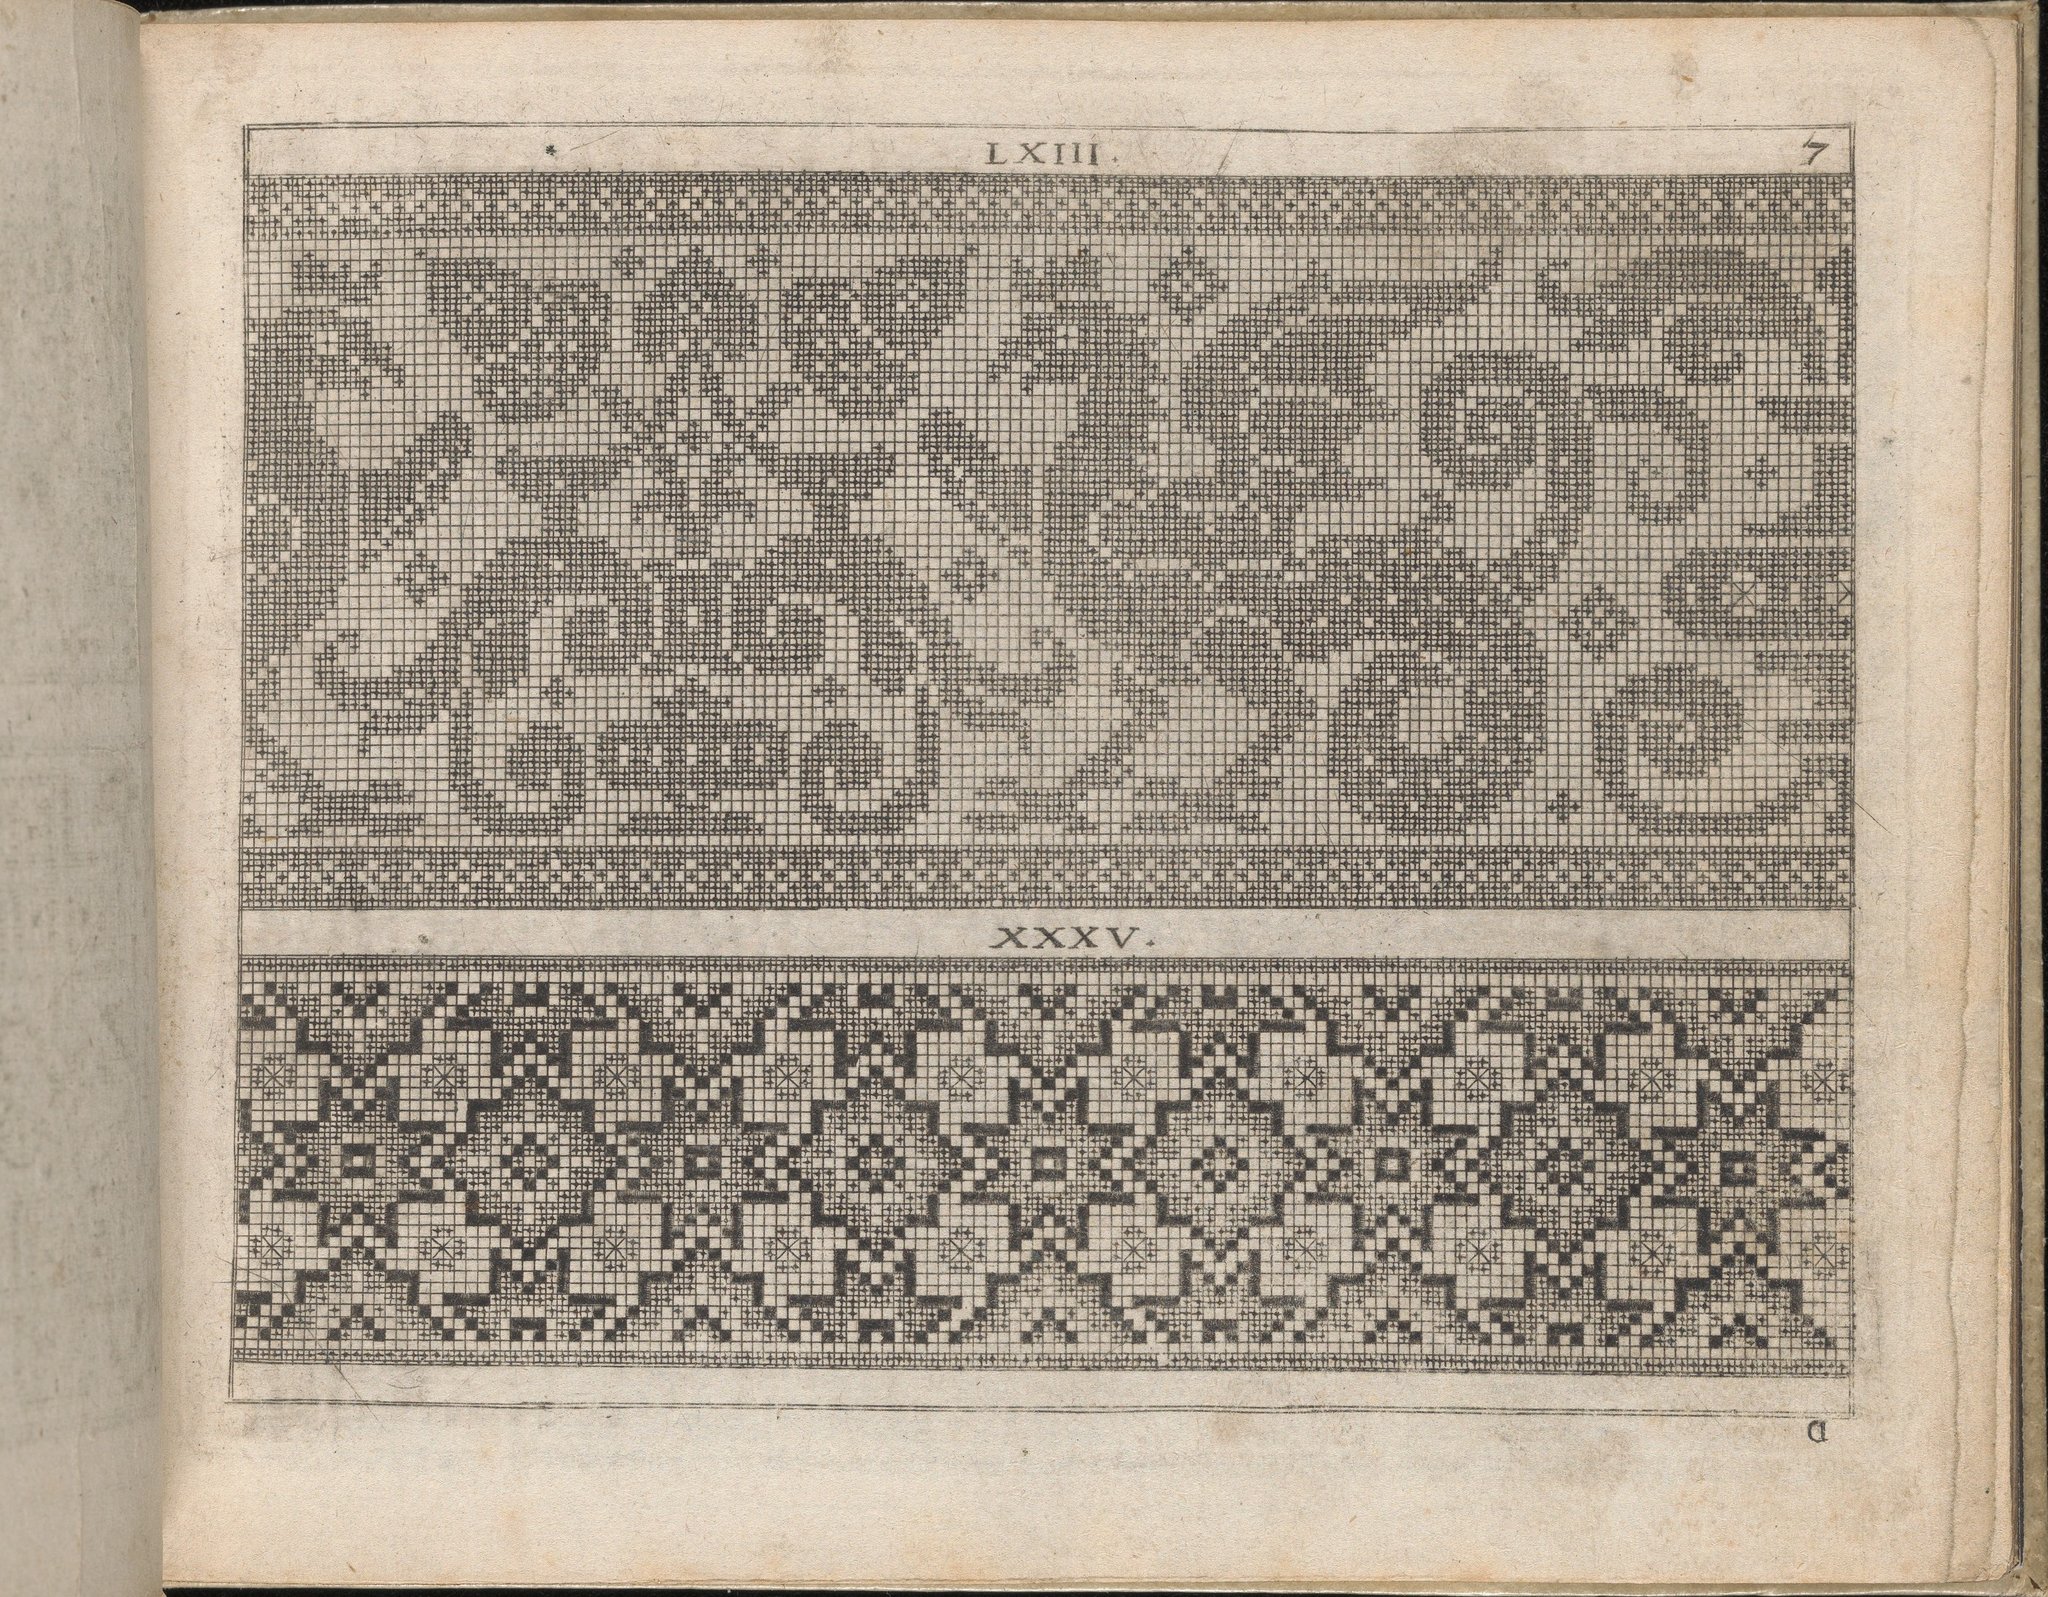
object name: book print ornament architecture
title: Newes Modelbuch in Kupffer (Page 16r)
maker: johann sibmacher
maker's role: artist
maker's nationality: german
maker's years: 1590-1611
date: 1604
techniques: etching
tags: fruit